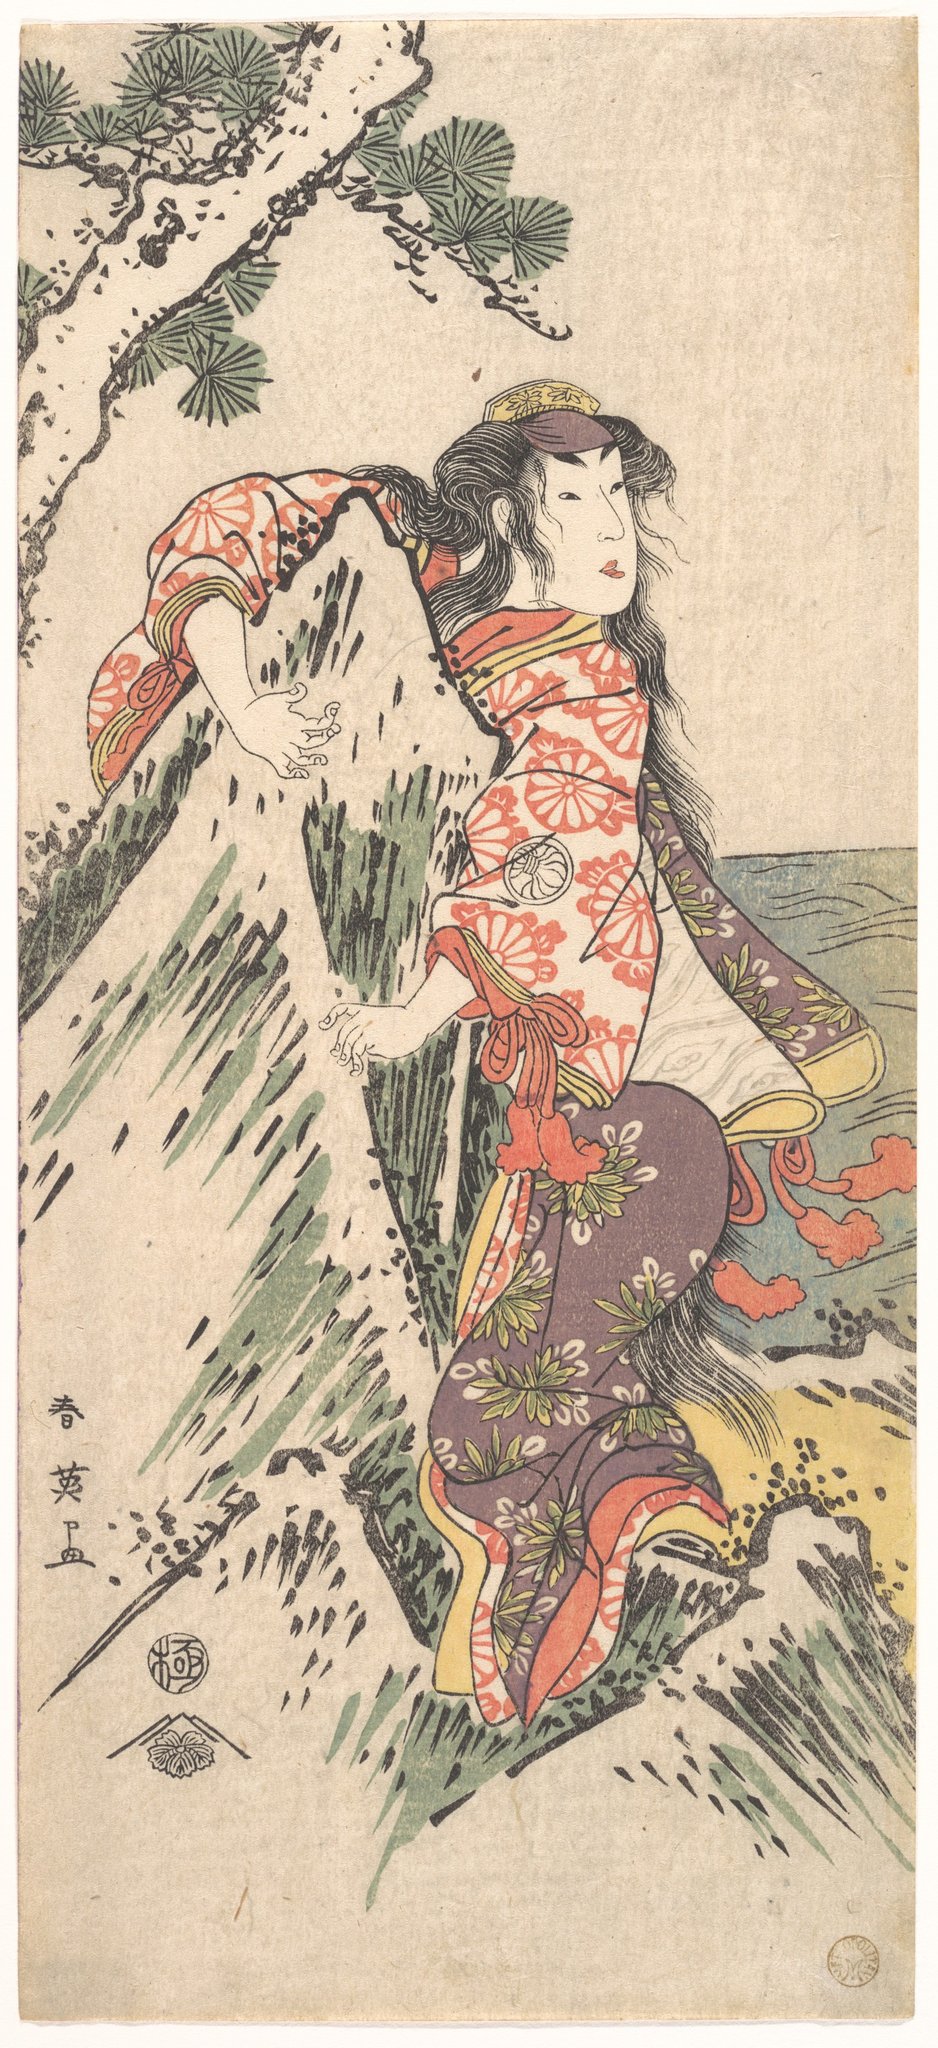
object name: print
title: Kabuki Actor Segawa Kikunojō III in a Female Role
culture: japanese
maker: katsukawa shun'ei 勝川春英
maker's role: artist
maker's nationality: japanese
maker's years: 1762-1819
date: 1788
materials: ink, paper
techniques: woodblock print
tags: trees,actors